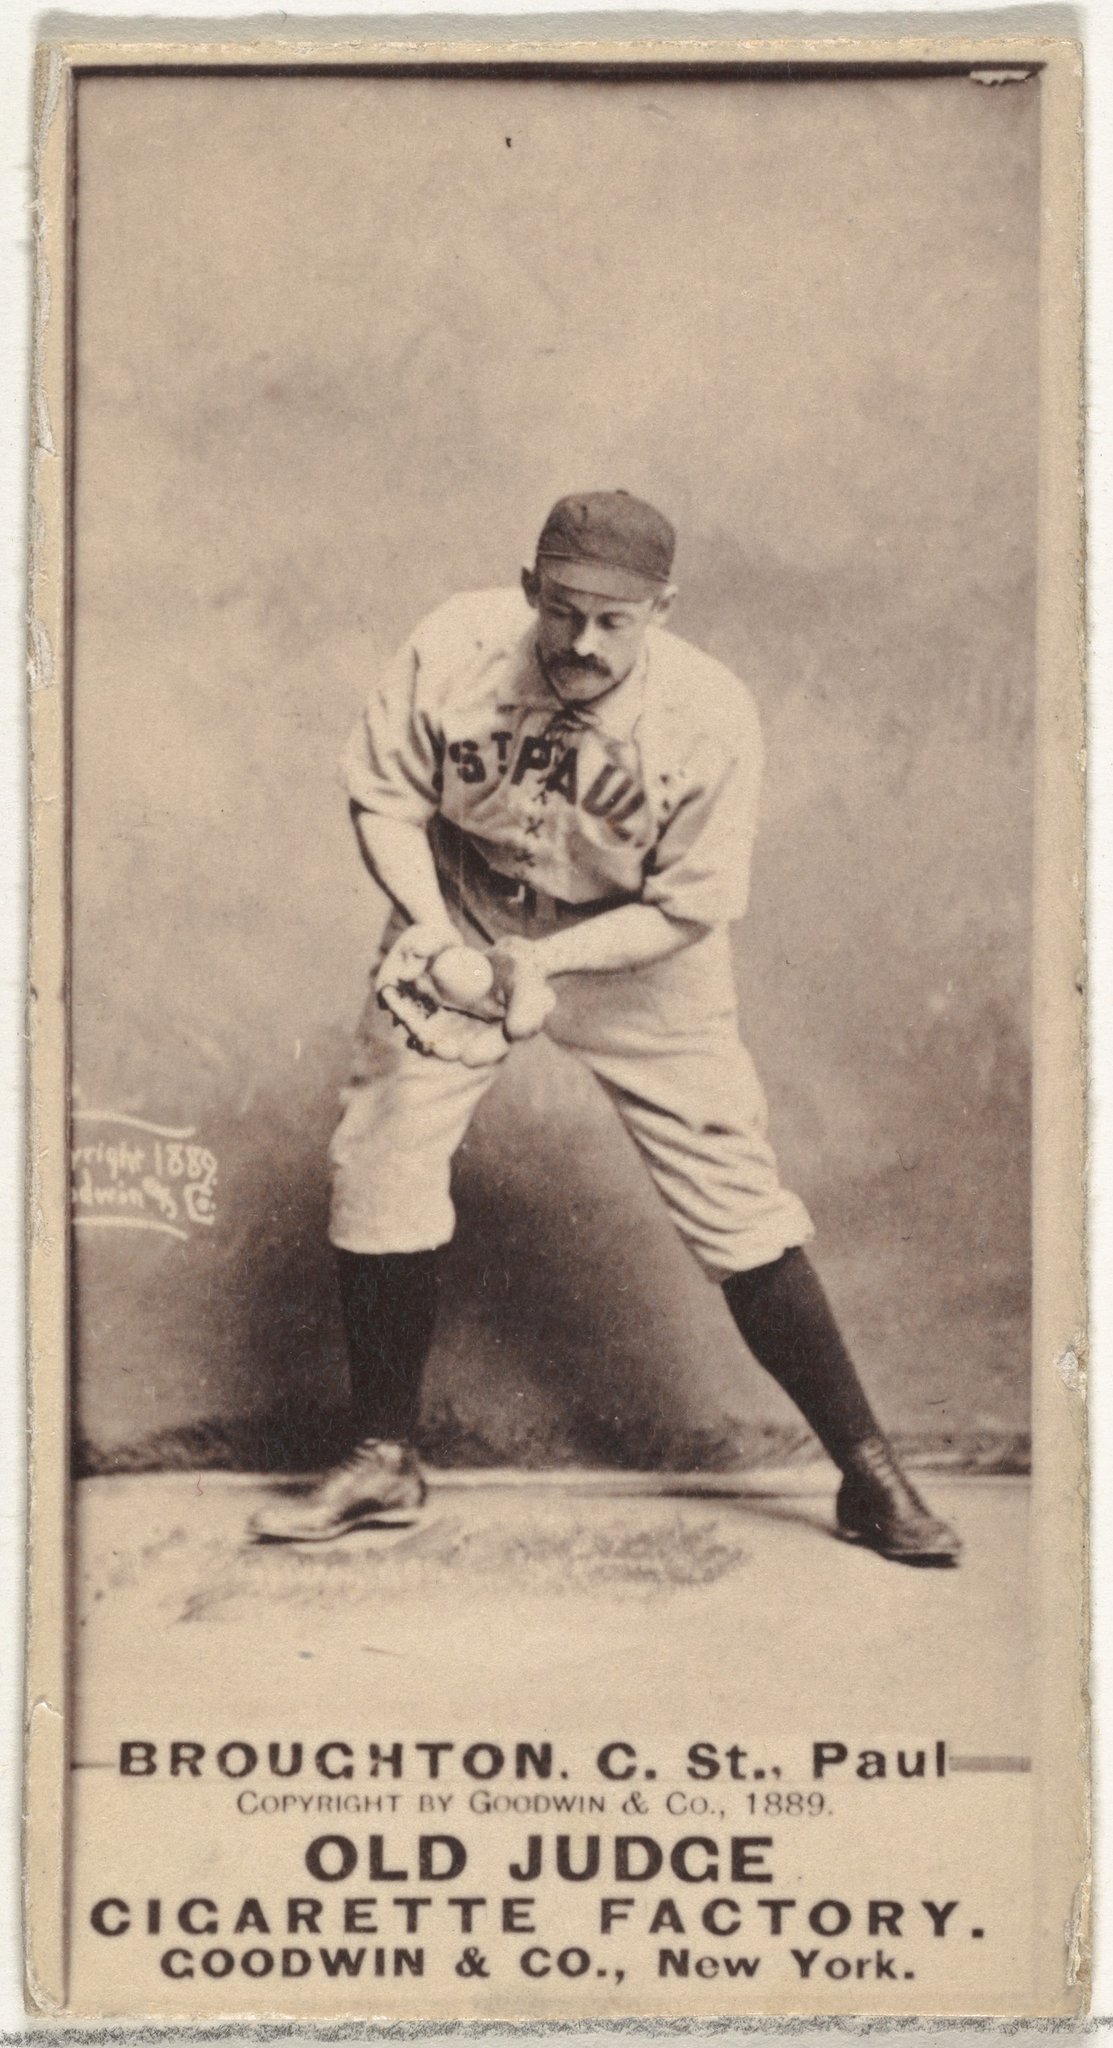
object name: baseball card, photograph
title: Cecil Calvert "Cal" Broughton, Catcher, St. Paul Apostles, from the Old Judge series (N172) for Old Judge Cigarettes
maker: goodwin & company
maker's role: publisher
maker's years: 1850-1950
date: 1889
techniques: albumen silver print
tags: men,portraits,baseball,athletes